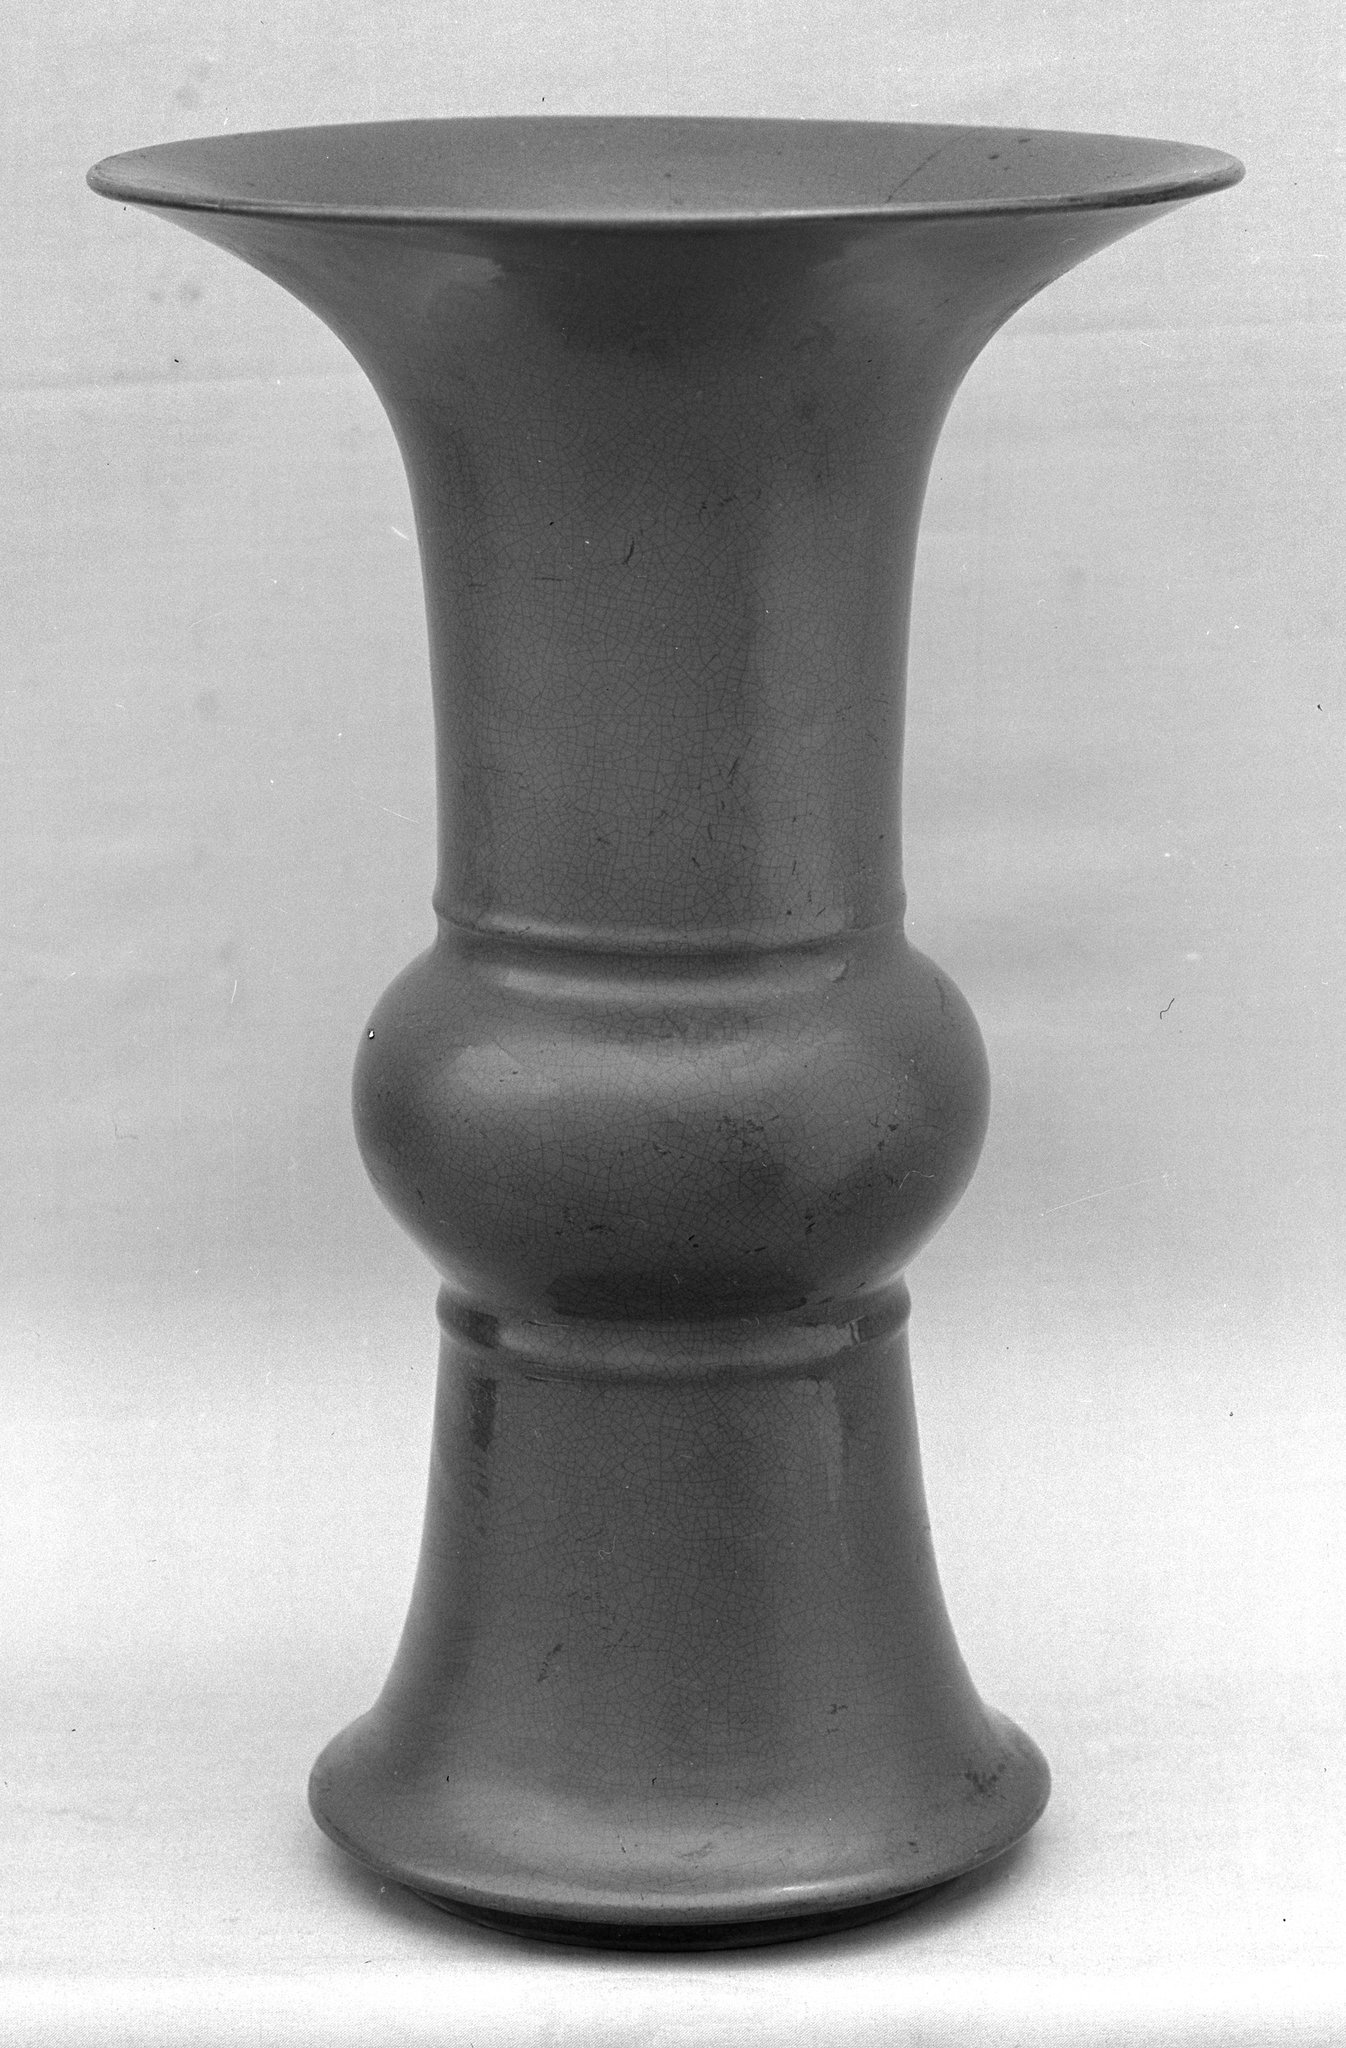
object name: vase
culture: chinese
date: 1736-1795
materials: porcelain